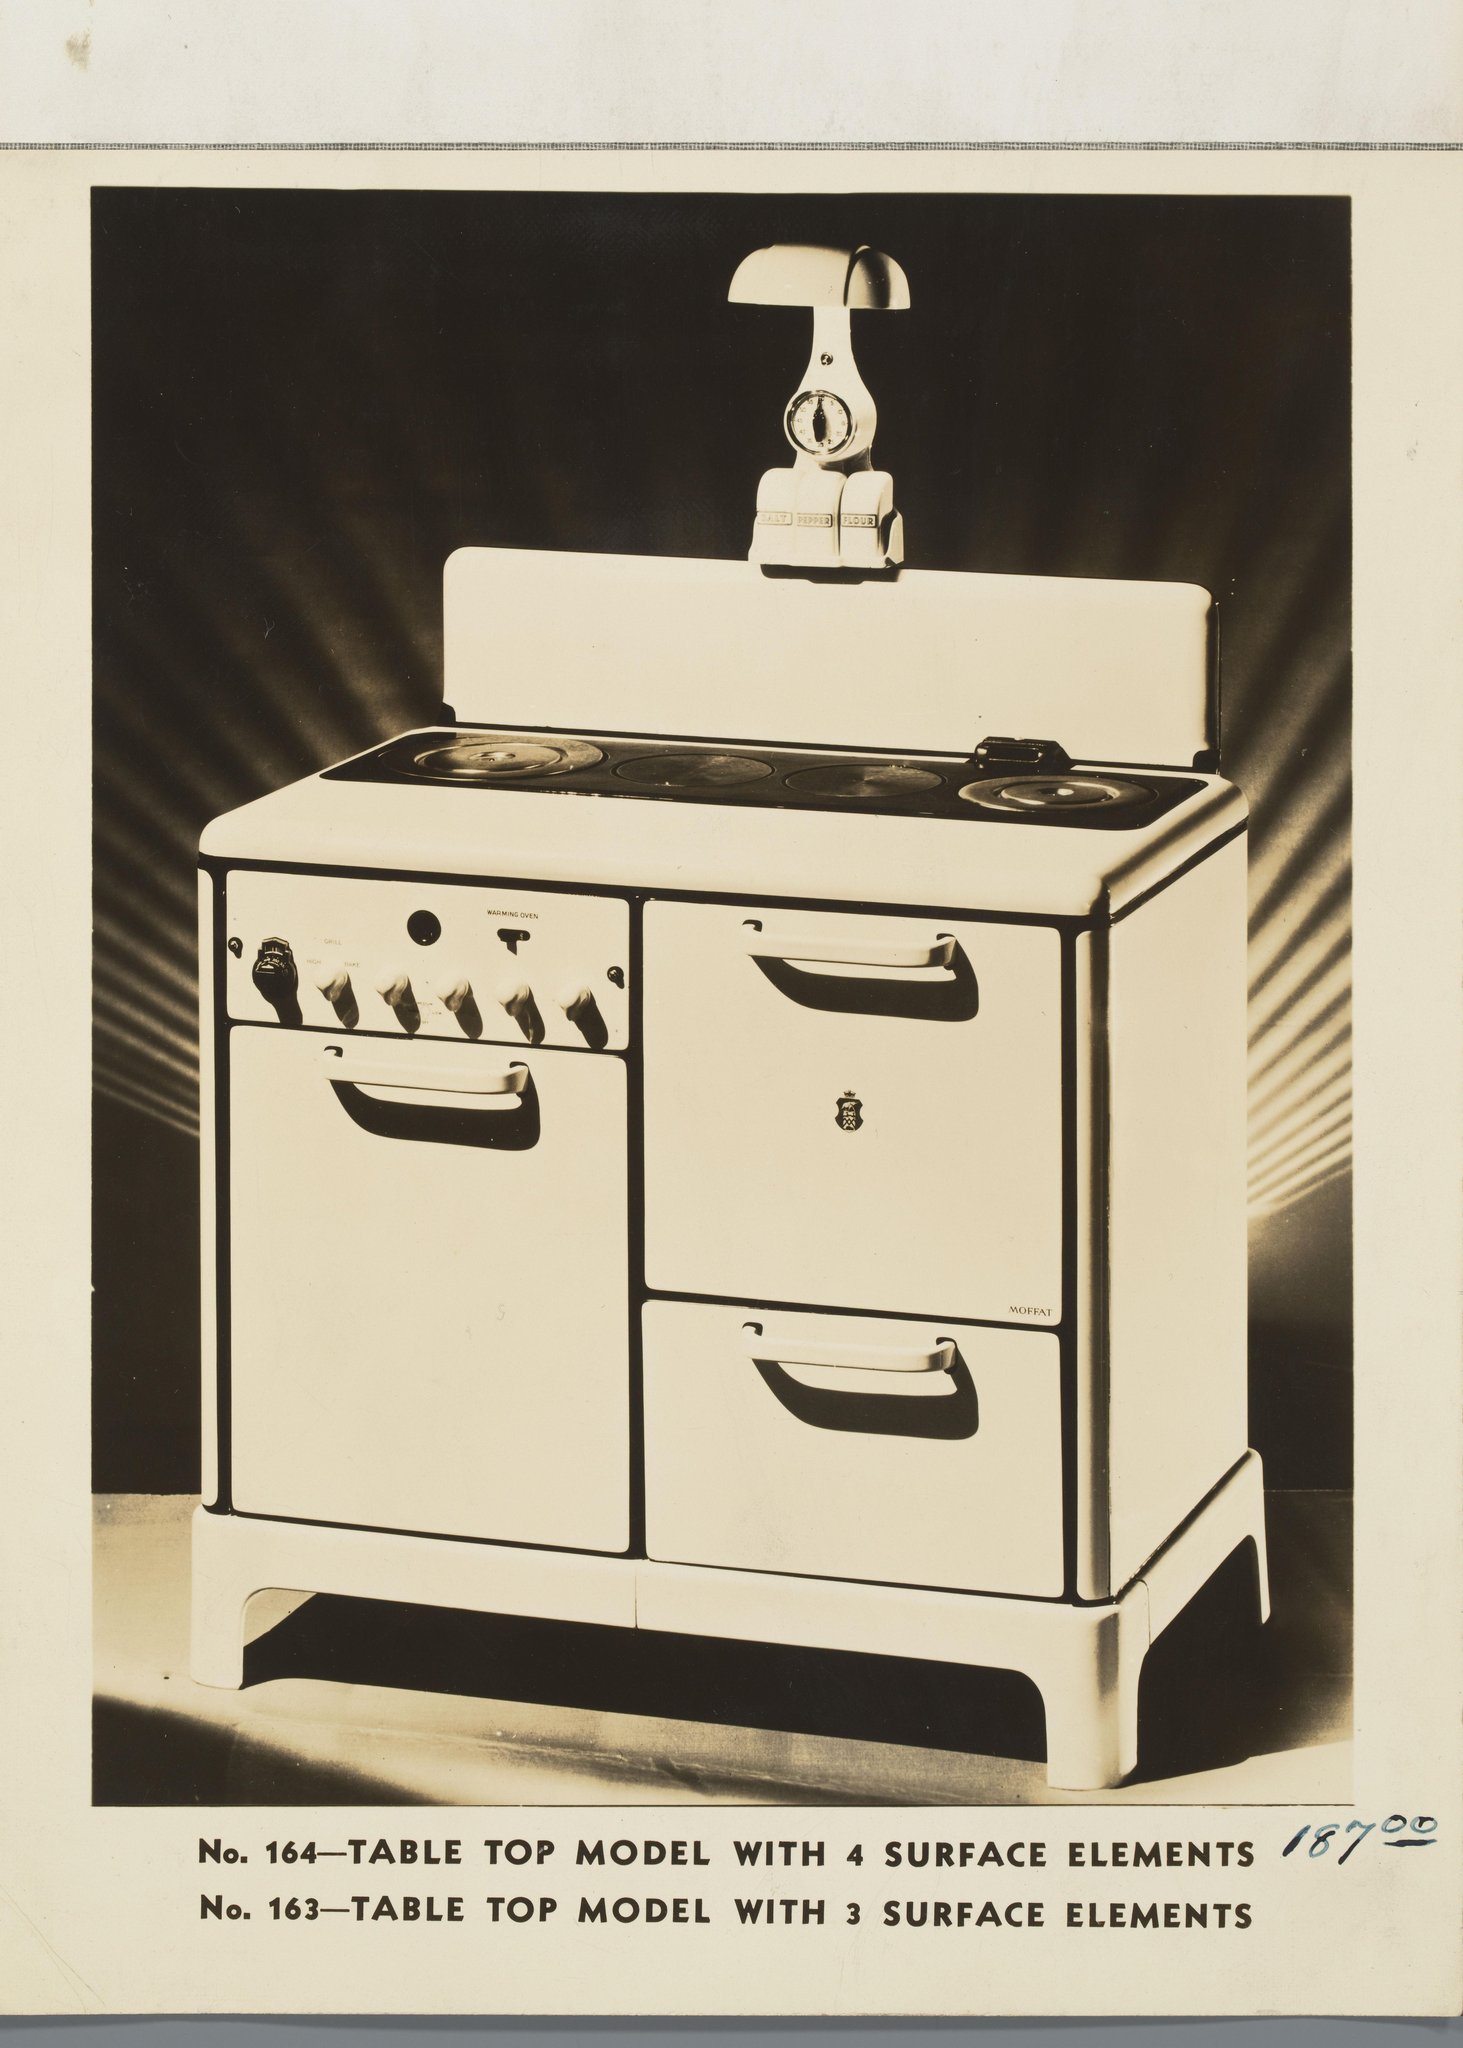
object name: photograph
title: Foto van Moffat ovens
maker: Anonymous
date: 1935-1940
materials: paper, photographic support, textile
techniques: gelatin silver print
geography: canada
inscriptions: inscription: ‘No. 164-TABLE TOP MODEL WITH 4 SURFACE ELEMENTS’, inscription: ‘18700’, inscription: ‘No. 163-TABLE TOP MODEL WITH 3 SURFACE ELEMENTS’